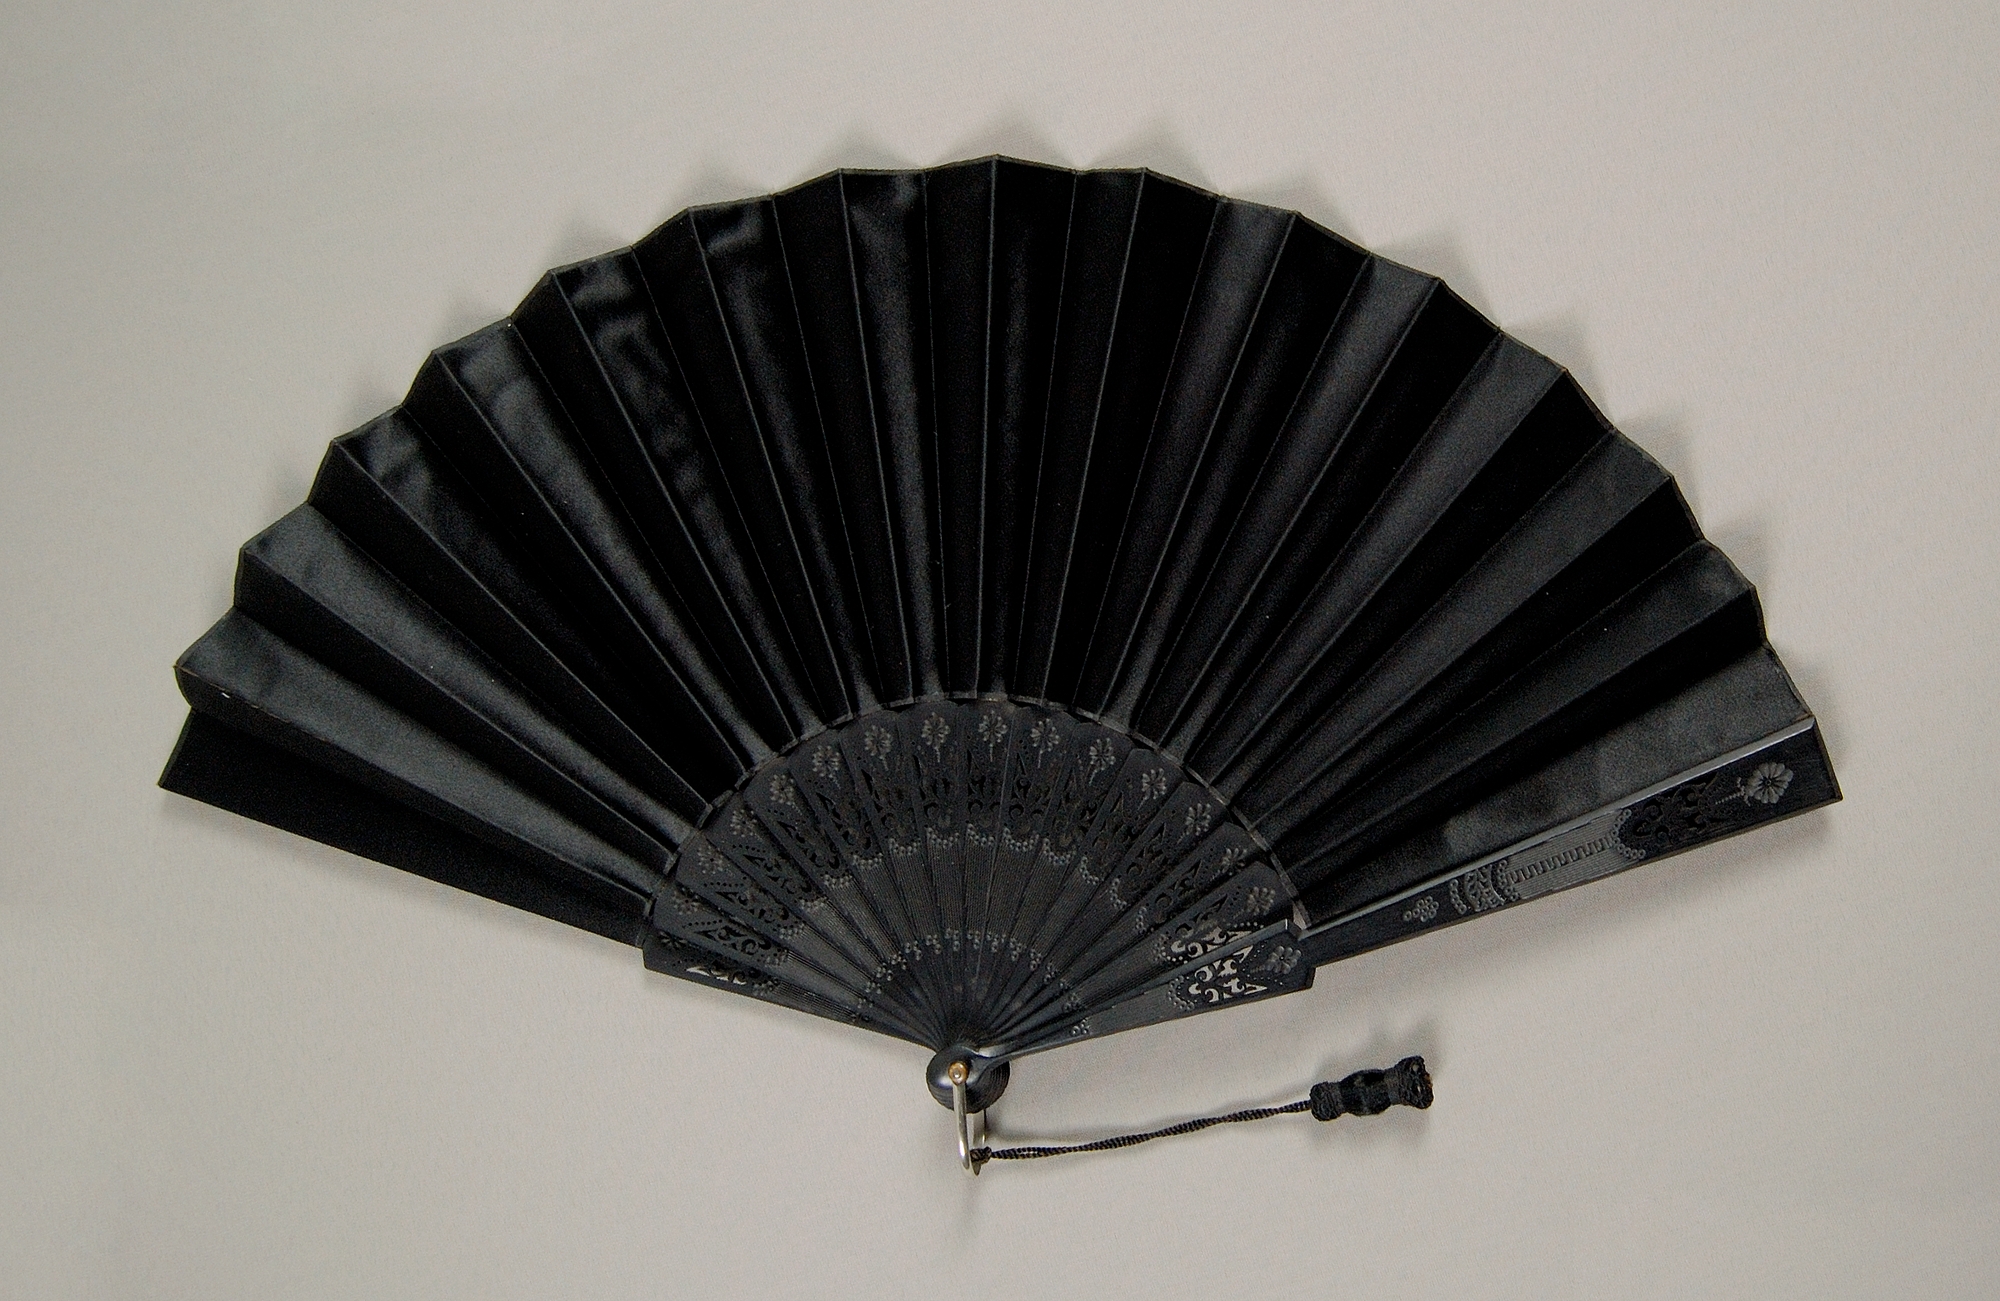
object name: mourning fan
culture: american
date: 1880-1889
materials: metal, plastic, silk, wood